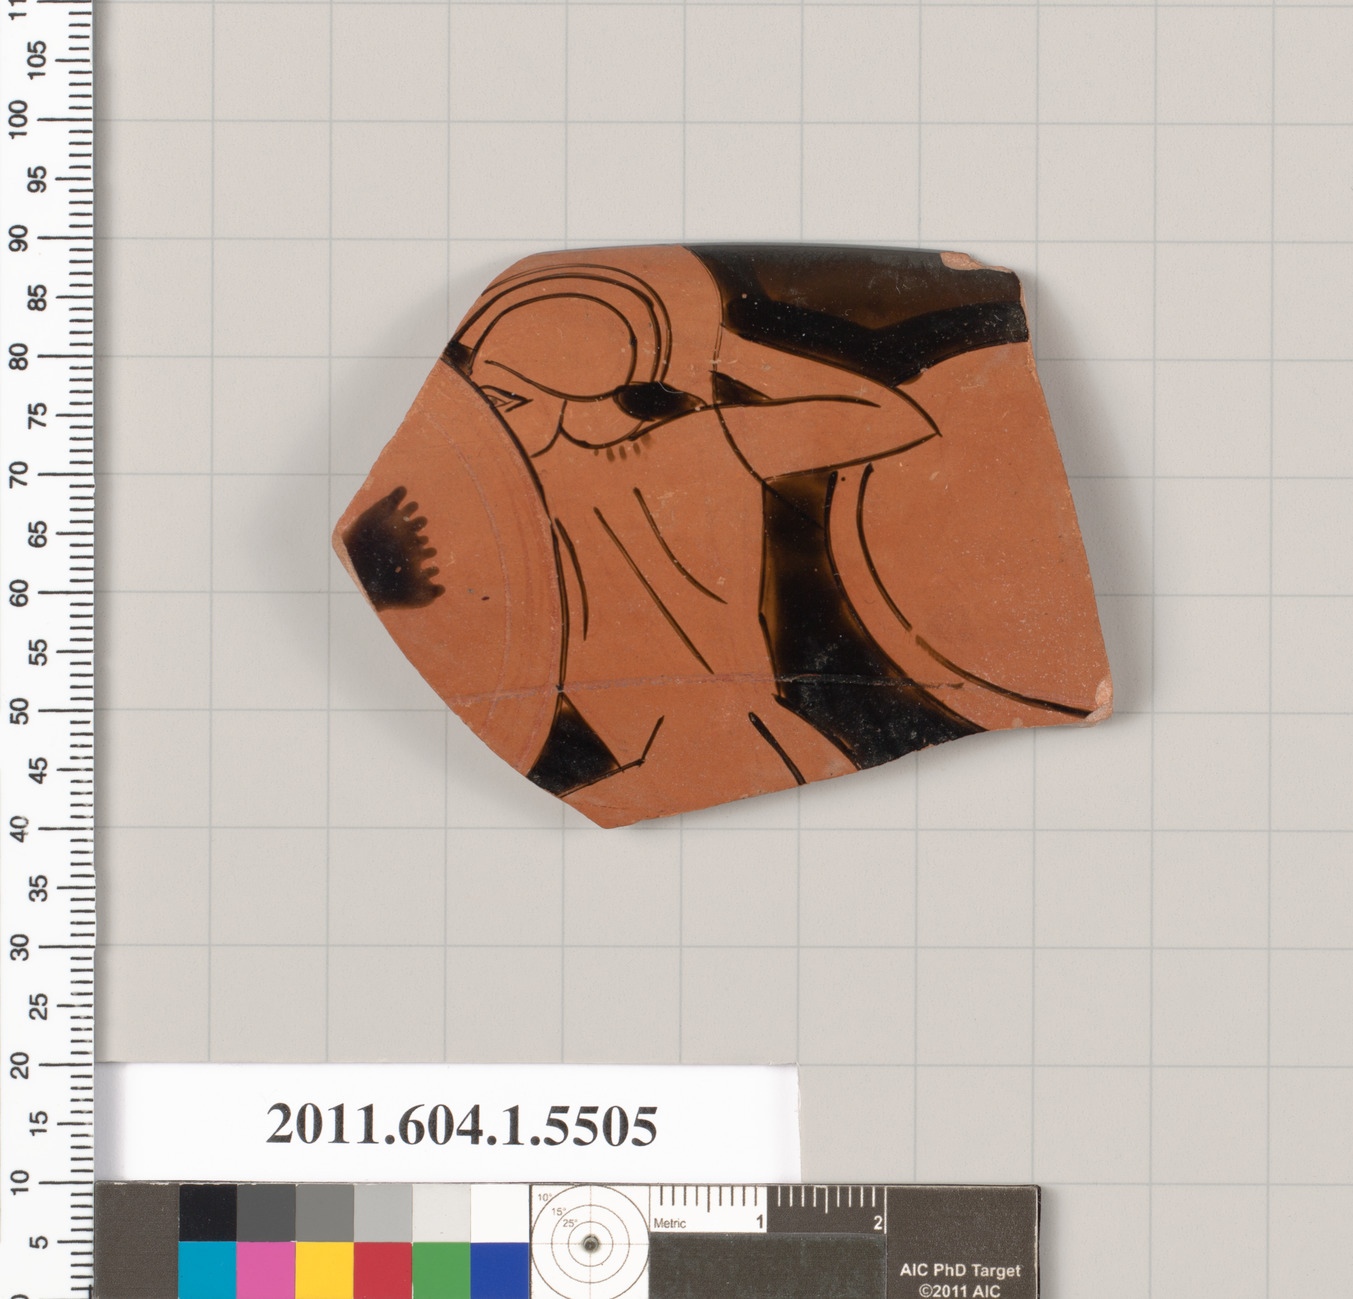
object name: kylix fragment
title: Terracotta rim fragment of a kylix (drinking cup)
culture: greek, attic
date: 520-510 BCE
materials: terracotta